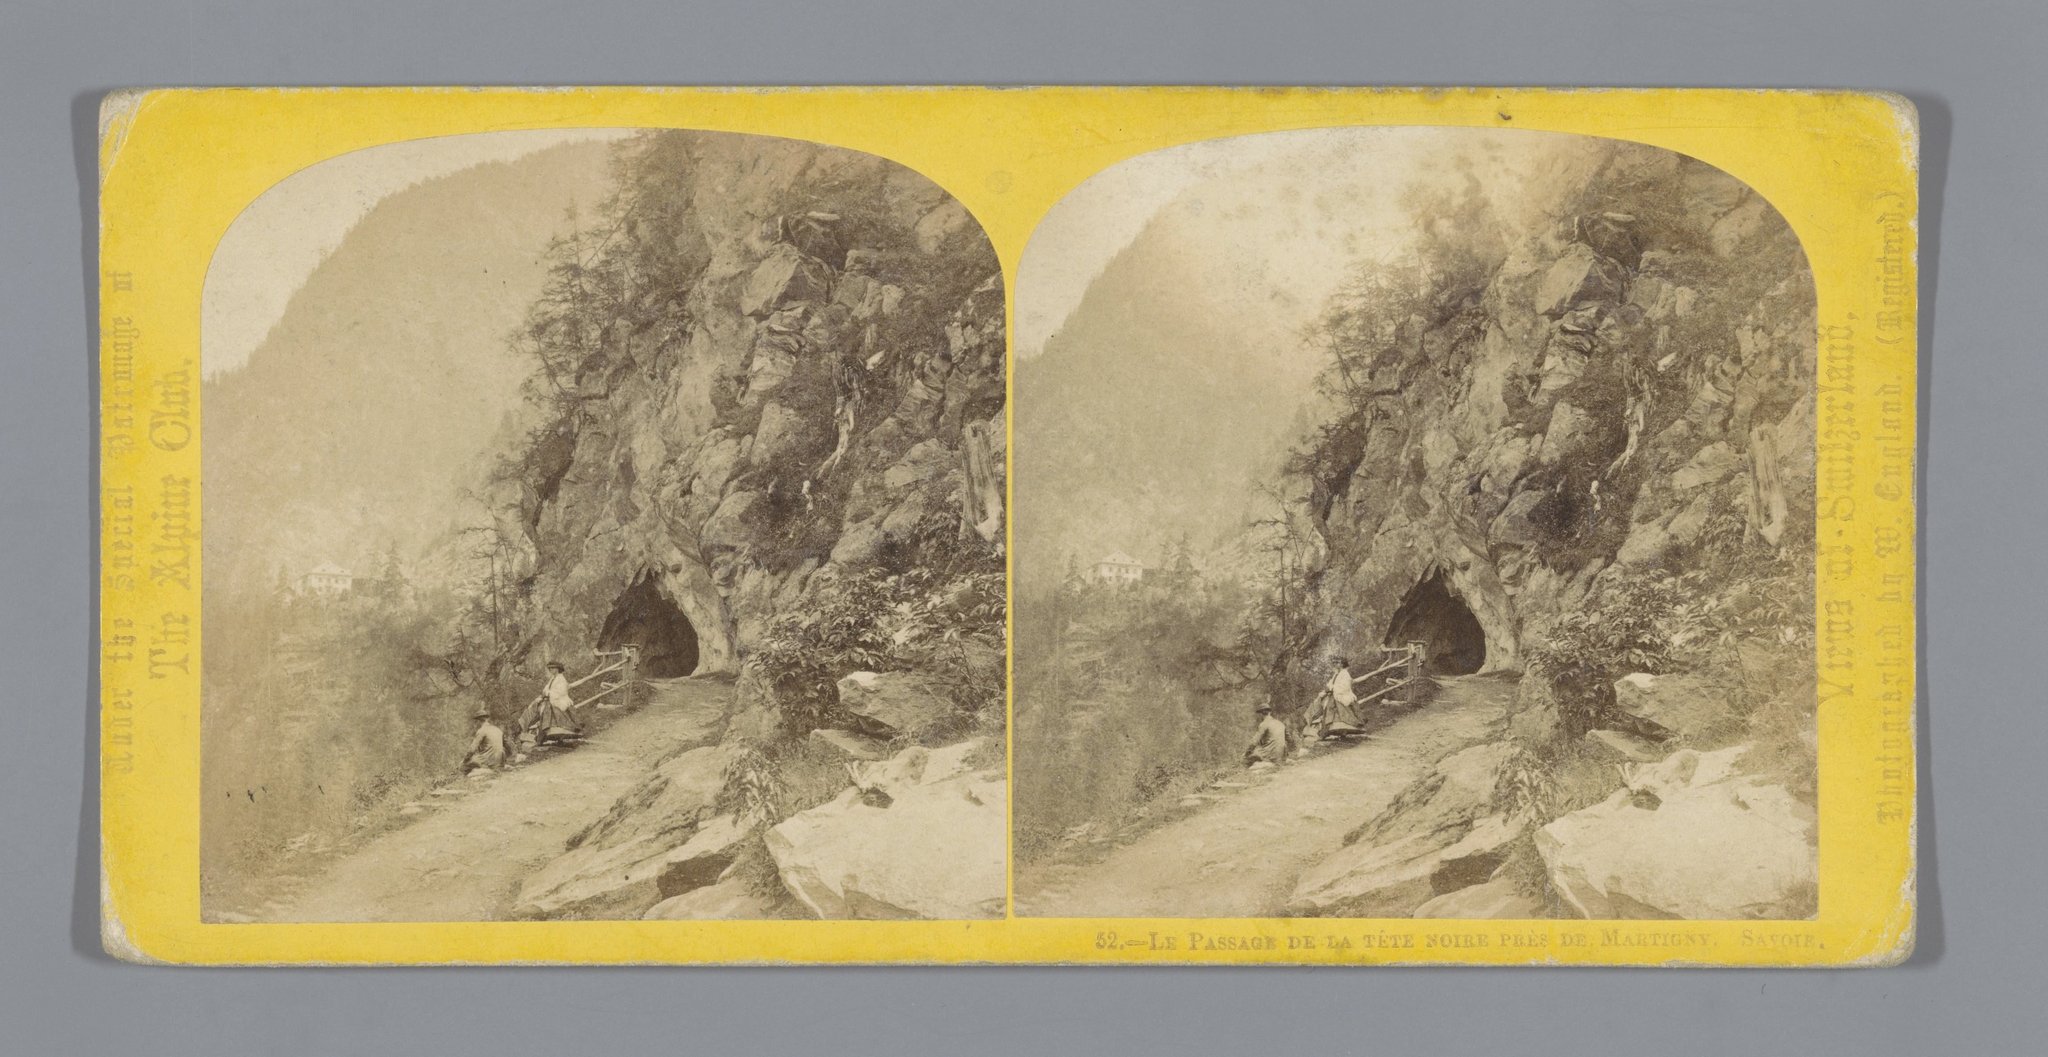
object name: stereograph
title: Le Passage de la tête noire près de Martigny. Savoie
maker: william england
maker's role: fotograaf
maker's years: 1816-1896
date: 1850-1880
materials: cardboard, photographic support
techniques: albumen print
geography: wallis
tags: underground road, tunnel, mountains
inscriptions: number: ‘52.’, inscription: ‘Views of Switzerland, photographed by W. England. (Registered) Under the Special Patronage of the Alpine Club.’